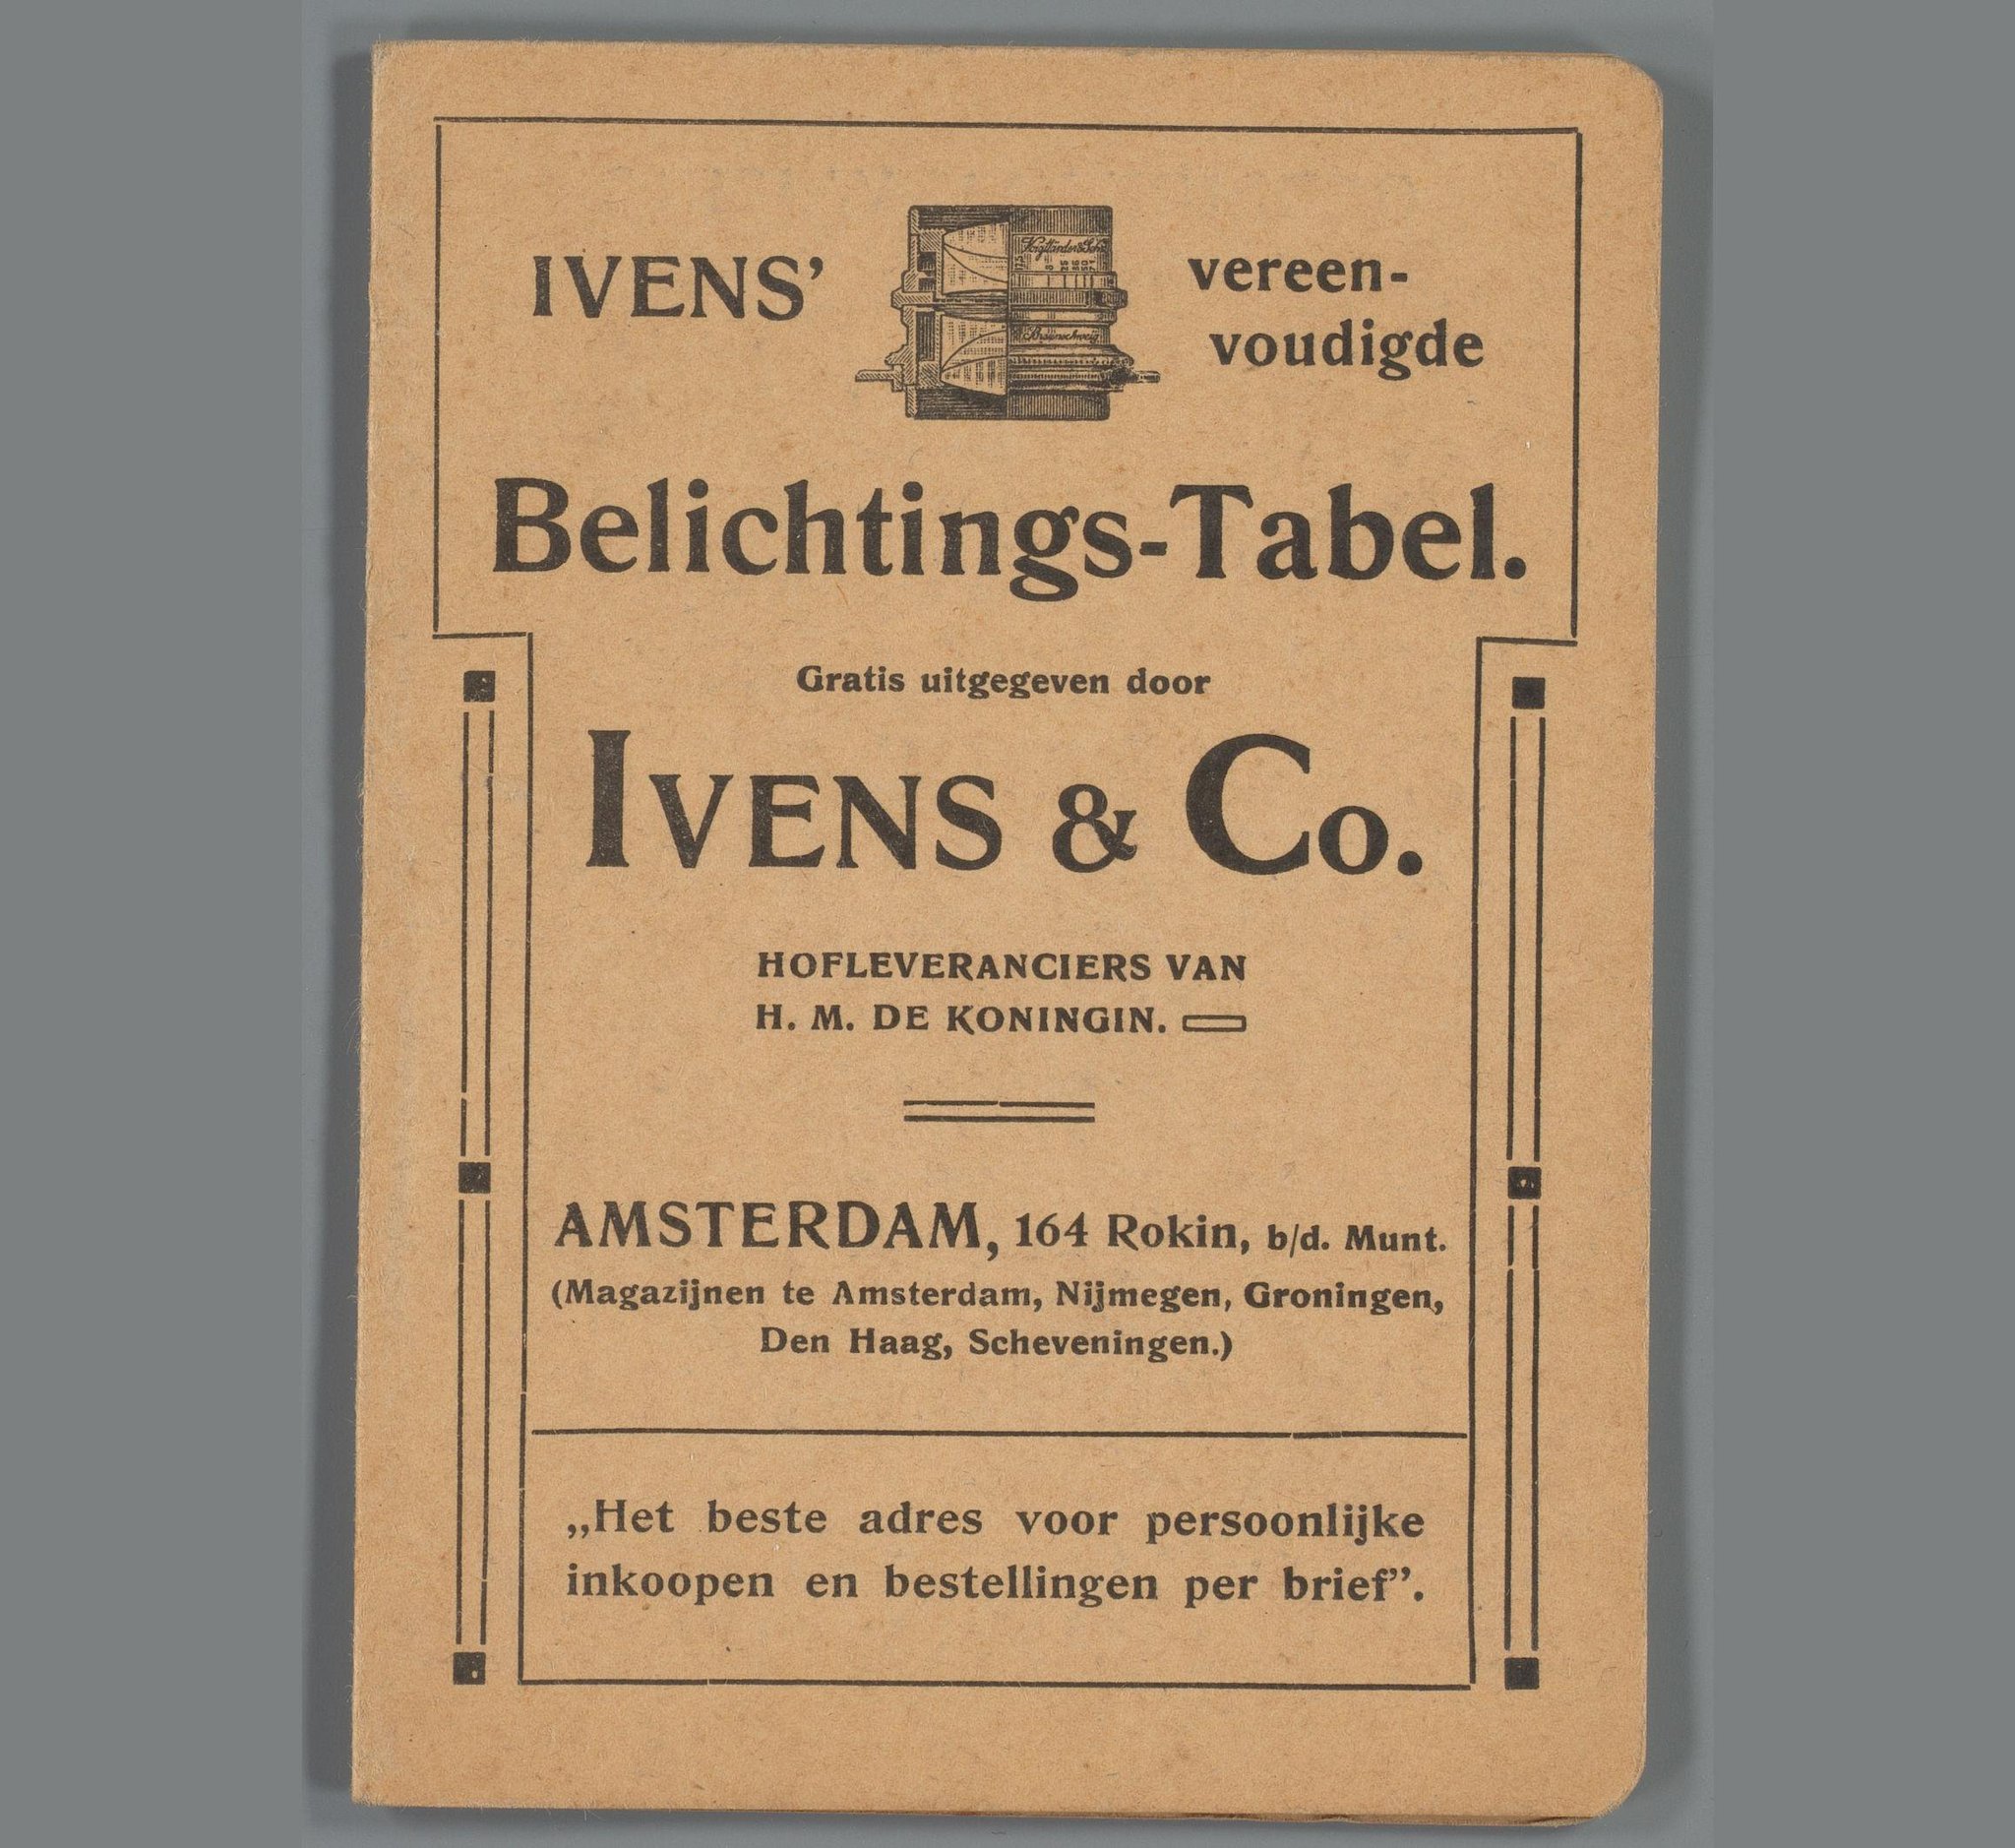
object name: light meter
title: Ivens' vereenvoudigde belichtings-tabel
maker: Anonymous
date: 1920-1930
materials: paper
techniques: printing block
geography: amsterdam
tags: photography, letter, envelope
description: Belichtingstabel als hulpmiddel voor het bepalen van de belichtingstijd bij diverse lichtsoorten, tijdstippen, weersomstandigheden en onderwerpen. De tabel werd gratis verstrekt door fotohandel Ivens & Co.